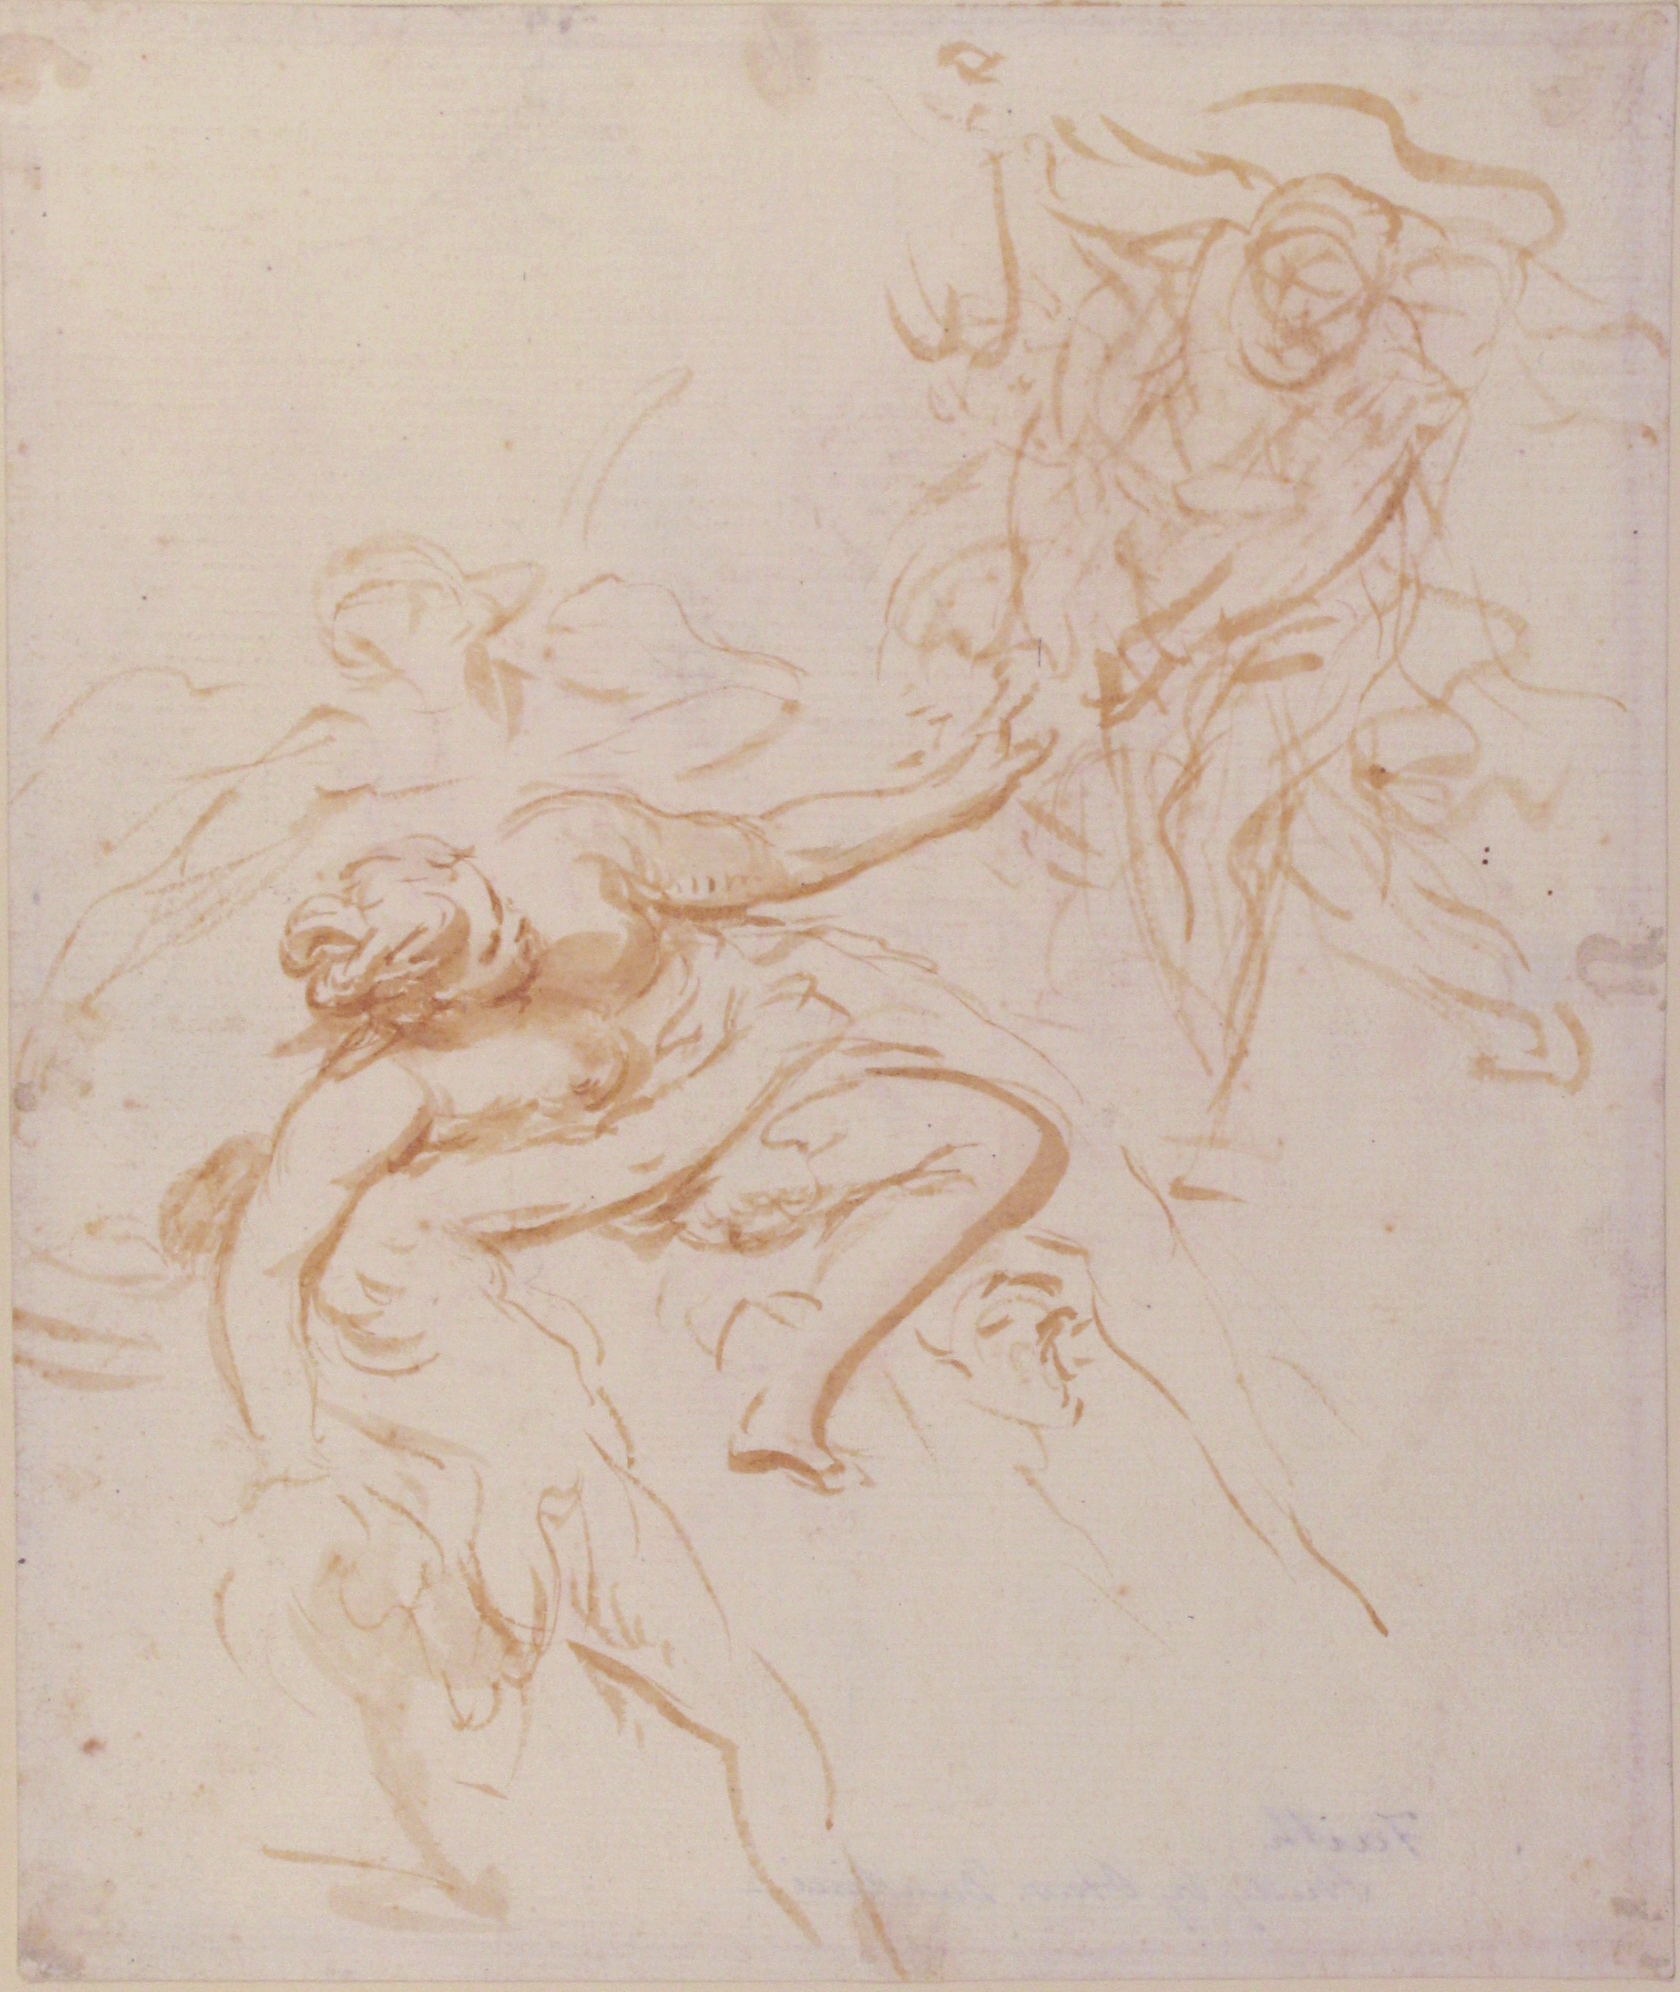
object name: drawing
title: Scene of Abduction (recto); Allegorical Figure of Christian Faith, Drawn over Faint Landscape Indications (verso)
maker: ottaviano dandini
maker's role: artist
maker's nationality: italian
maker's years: 1681-1740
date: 1706-1740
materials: chalk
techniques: brush, wash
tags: female nudes